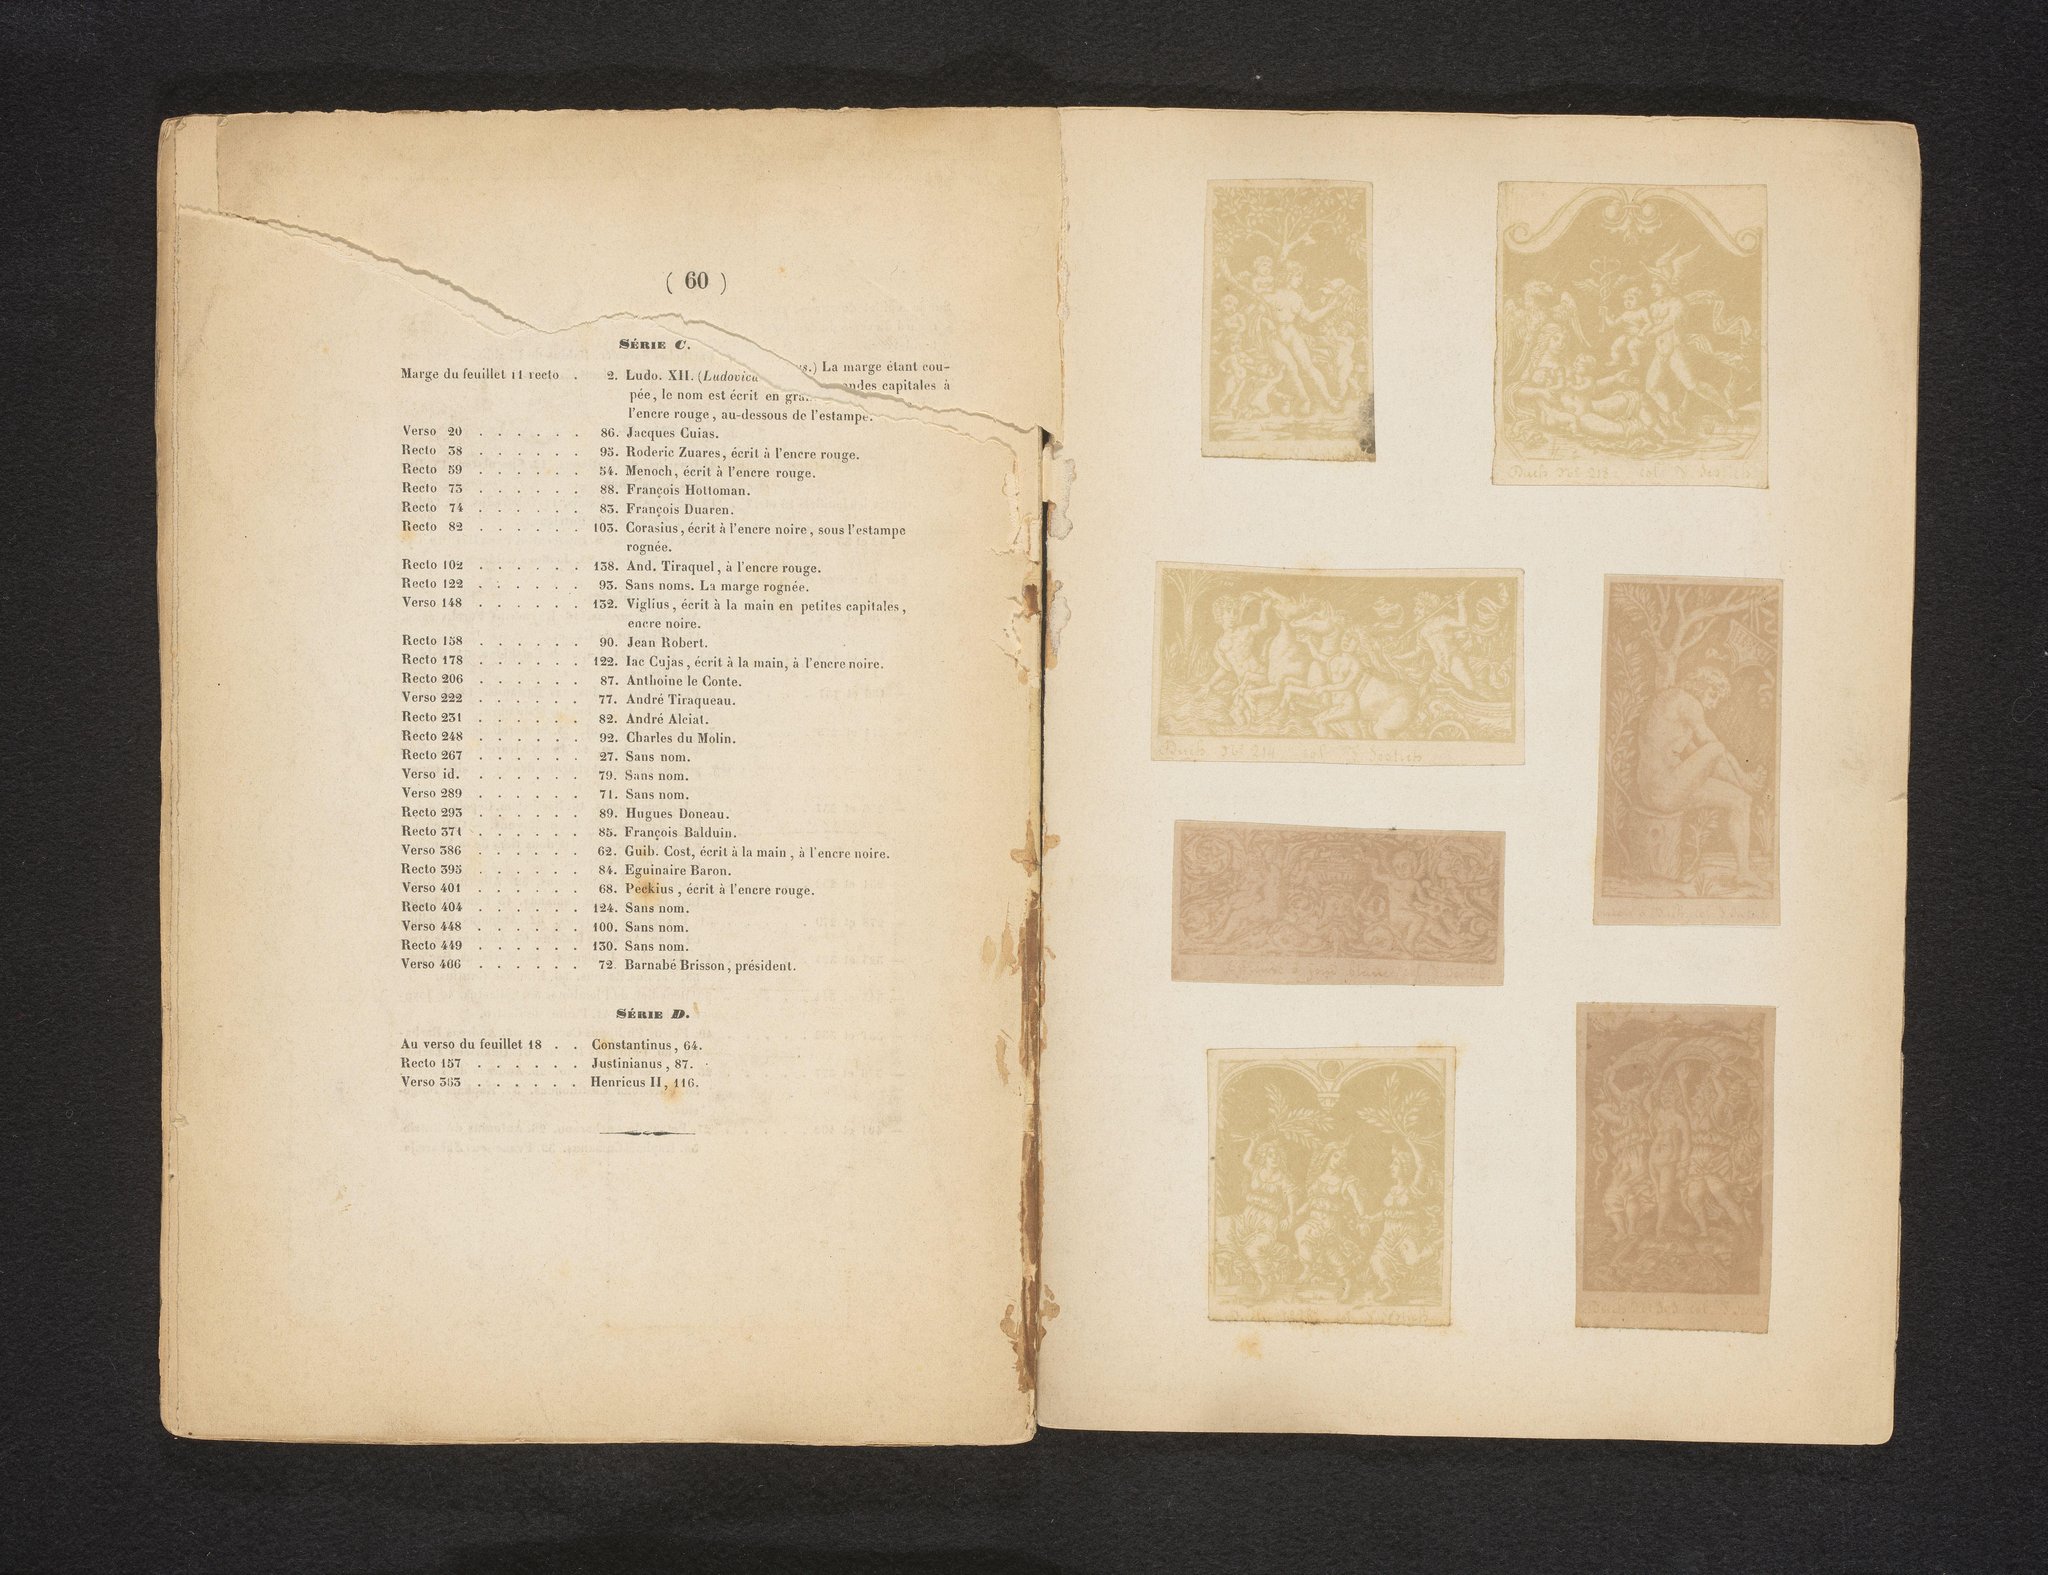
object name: photograph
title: Fotoreproductie van een prent van drie dansende vrouwen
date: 1852-1857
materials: photographic support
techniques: salted paper print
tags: adult woman, dancing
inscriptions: inscription: ‘Duch. No 287 - col. V. Sestich’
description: Foto op blad met zeven foto's tegenover pagina 60.